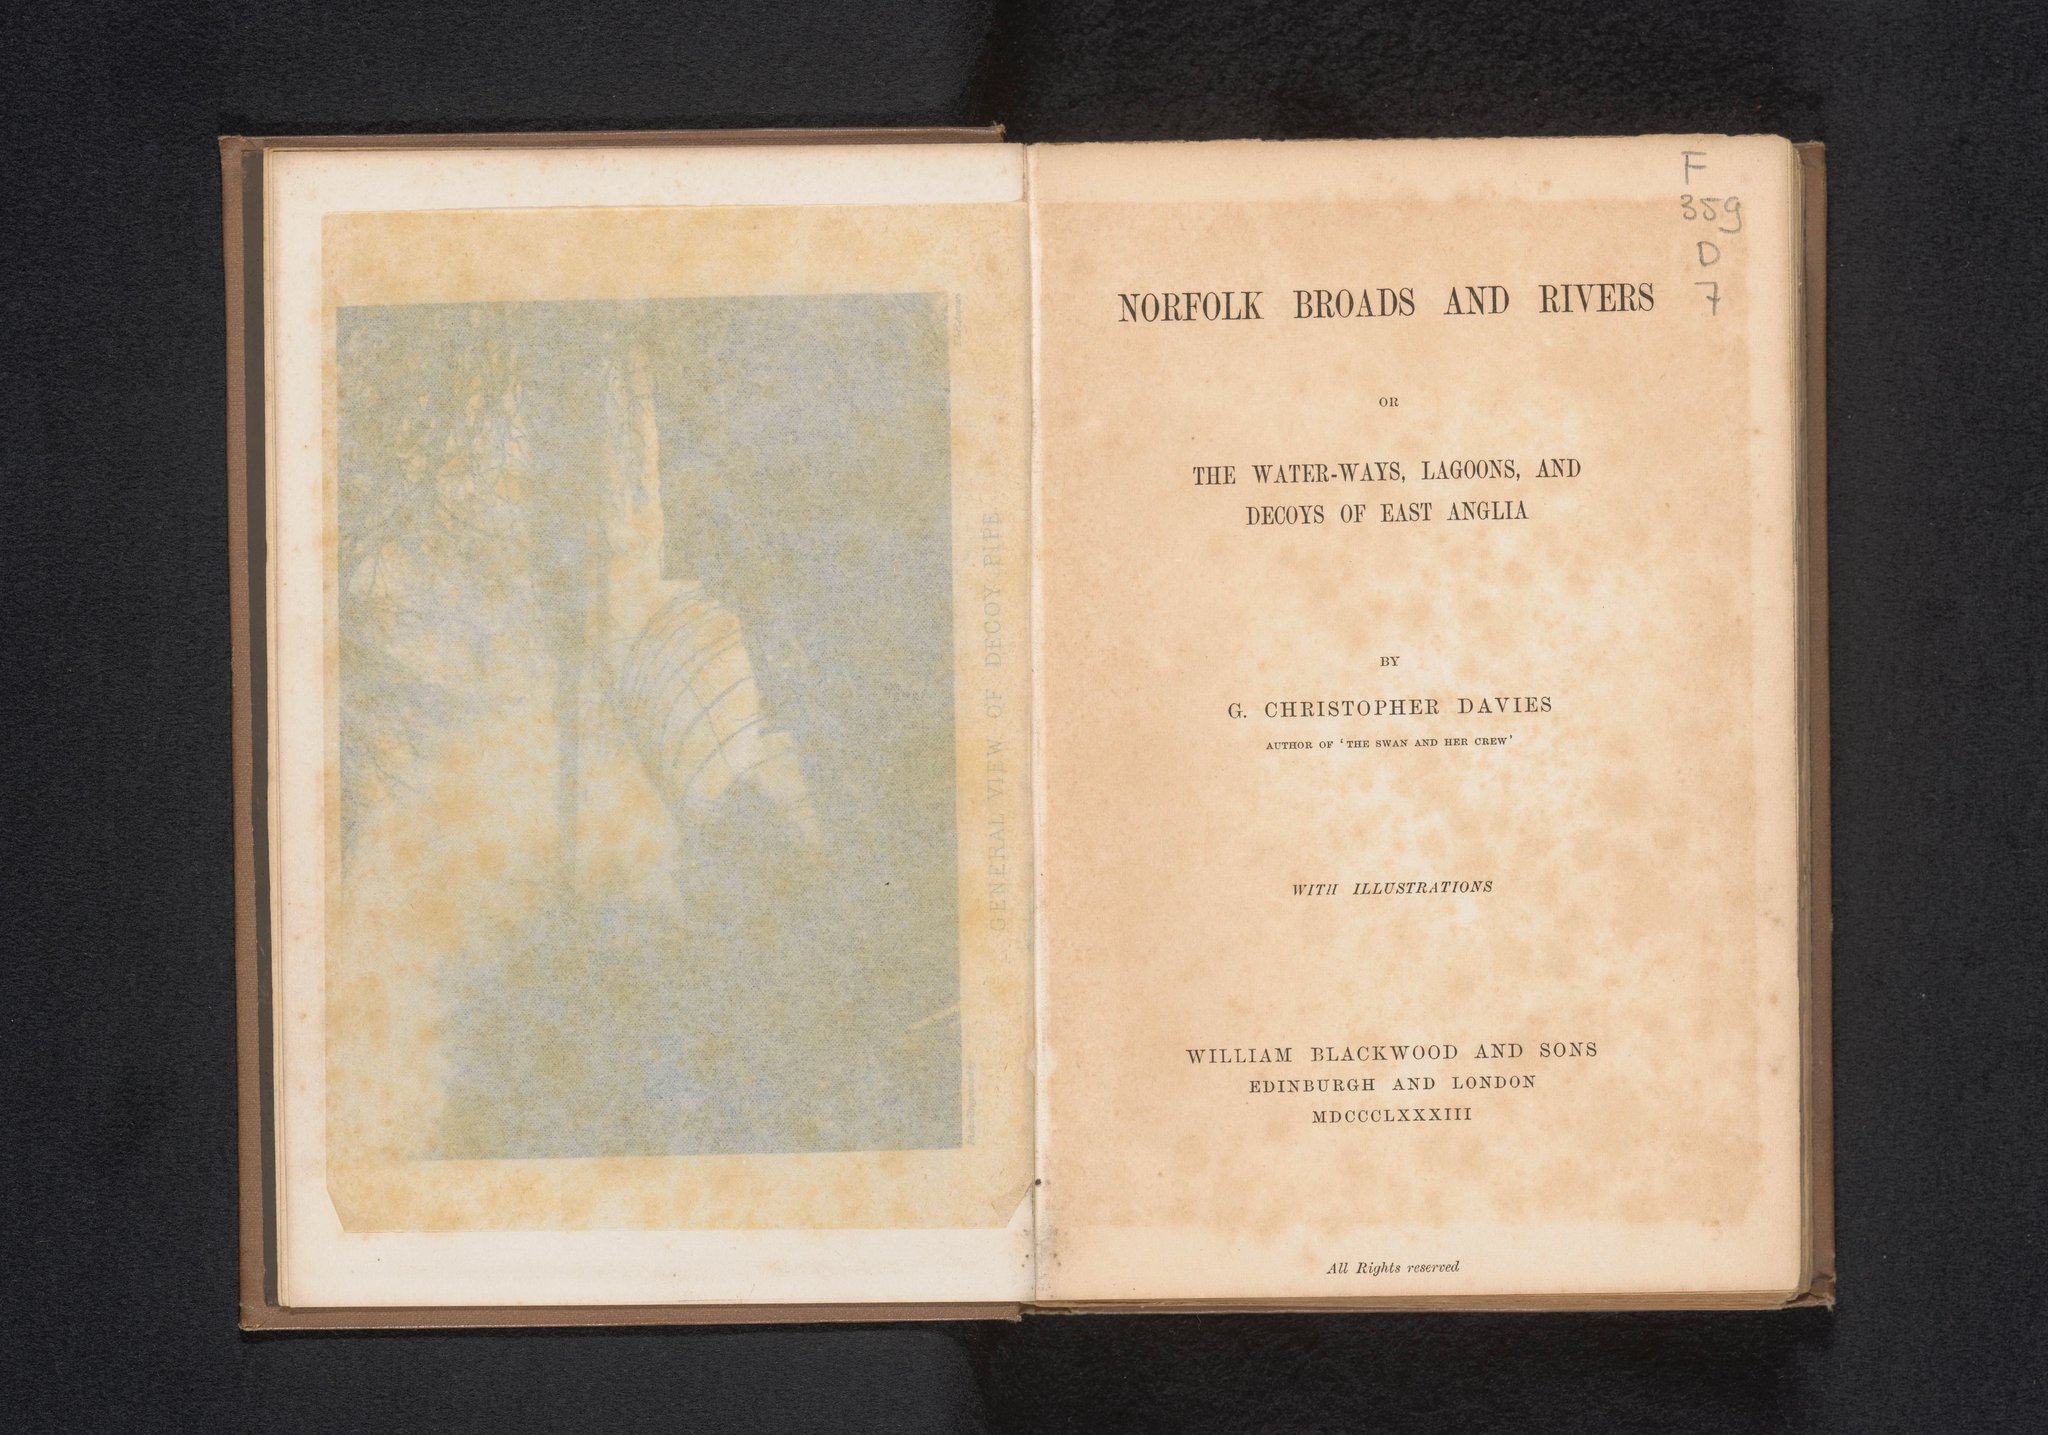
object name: book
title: Norfolk broads and rivers : or, The water-ways, lagoons, and decoys of East Anglia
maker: george christopher davies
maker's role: fotograaf, geoloog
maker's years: 1849-1922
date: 1883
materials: linen, paper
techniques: photoaquatint, printing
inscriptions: annotation: ‘1883, €85/ staining bp 134/5/ 144/5’, date: ‘Sept 1993’